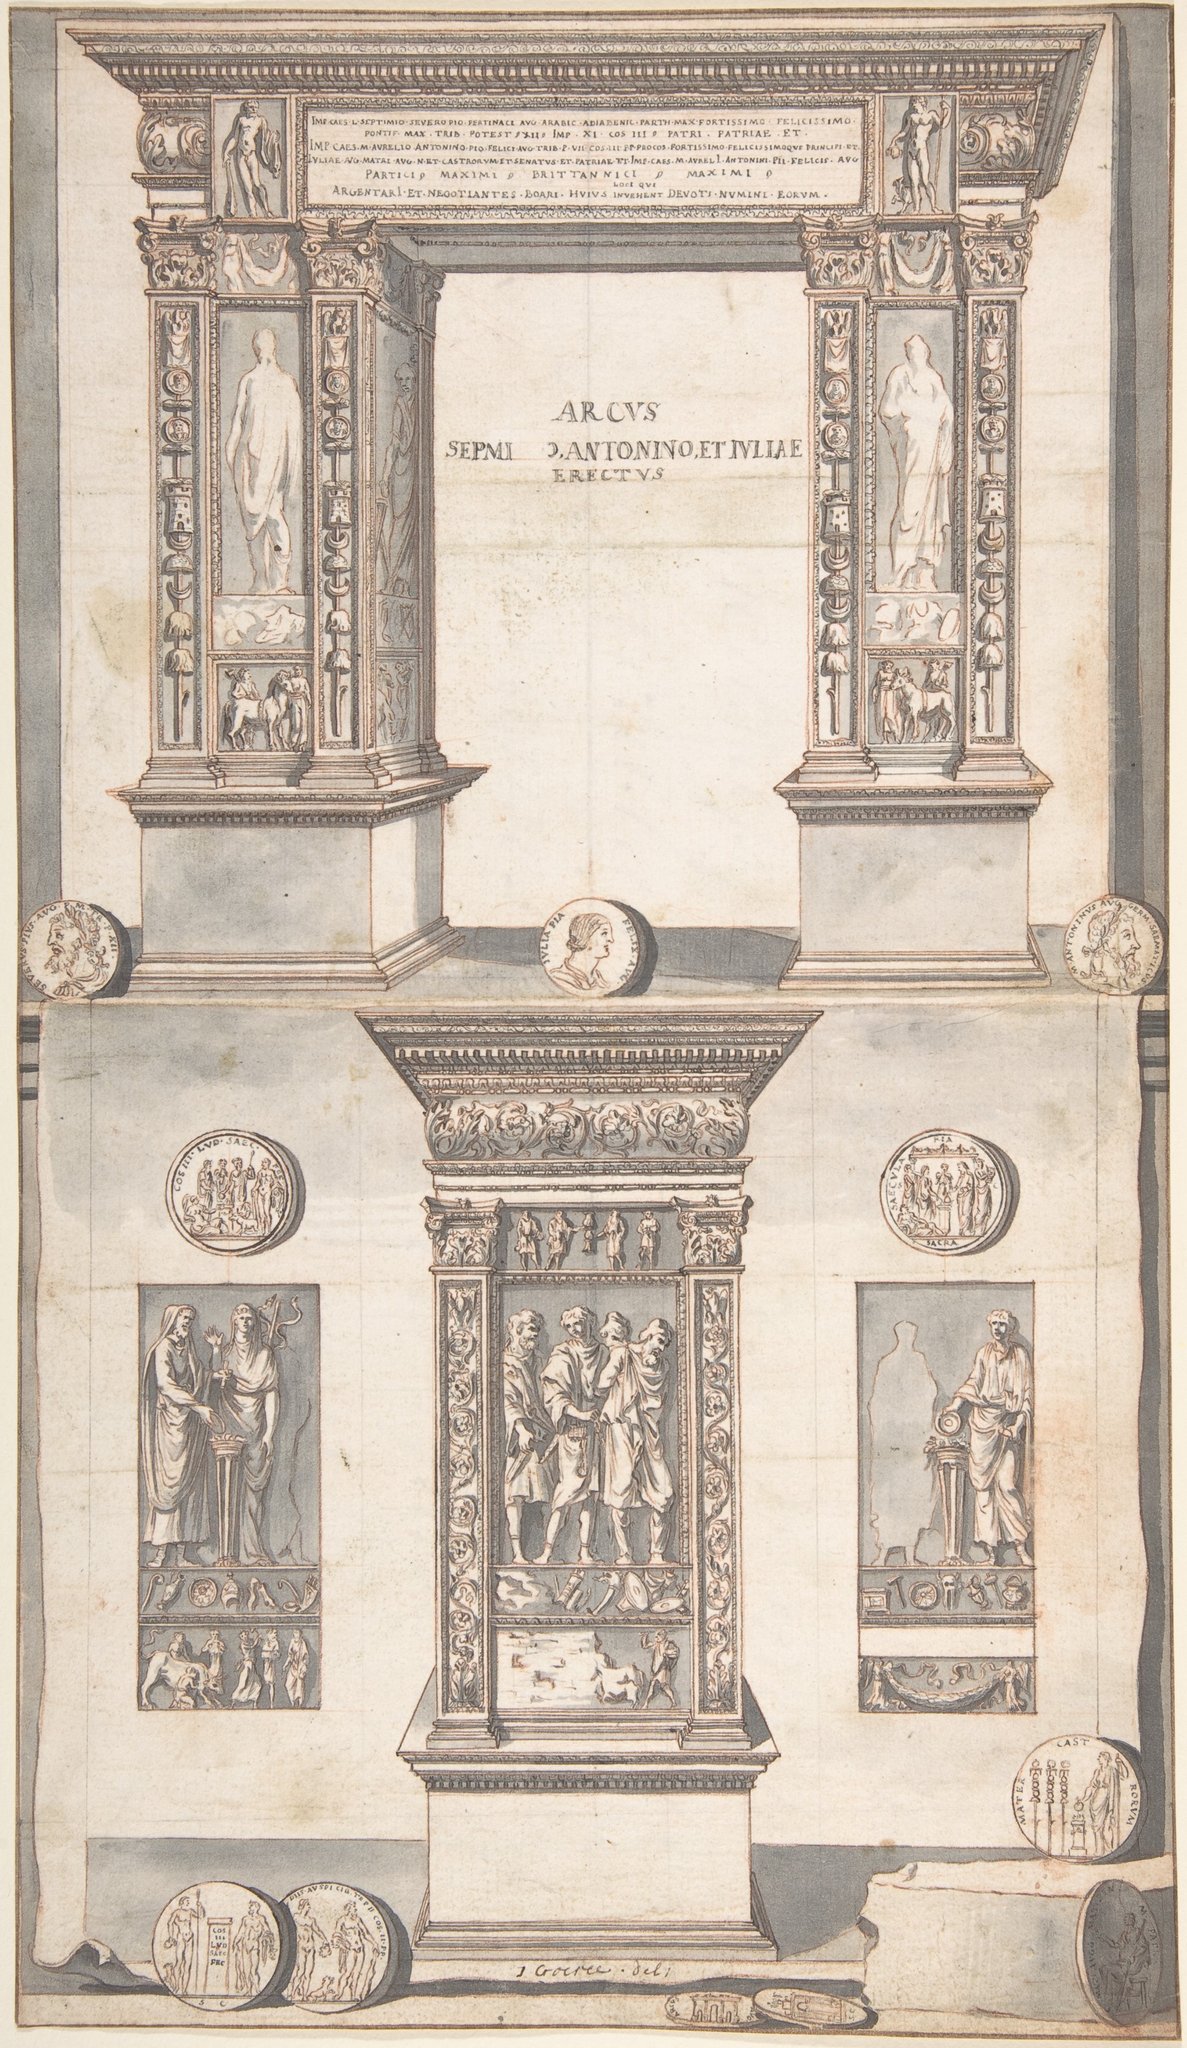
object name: drawing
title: Arch of Septimius Severus, Frontal Elevation (above) and Side View (below)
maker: jan goeree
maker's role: artist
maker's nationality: dutch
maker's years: 1670-1731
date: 1704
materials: chalk, ink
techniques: brush, pen, wash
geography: italy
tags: architecture